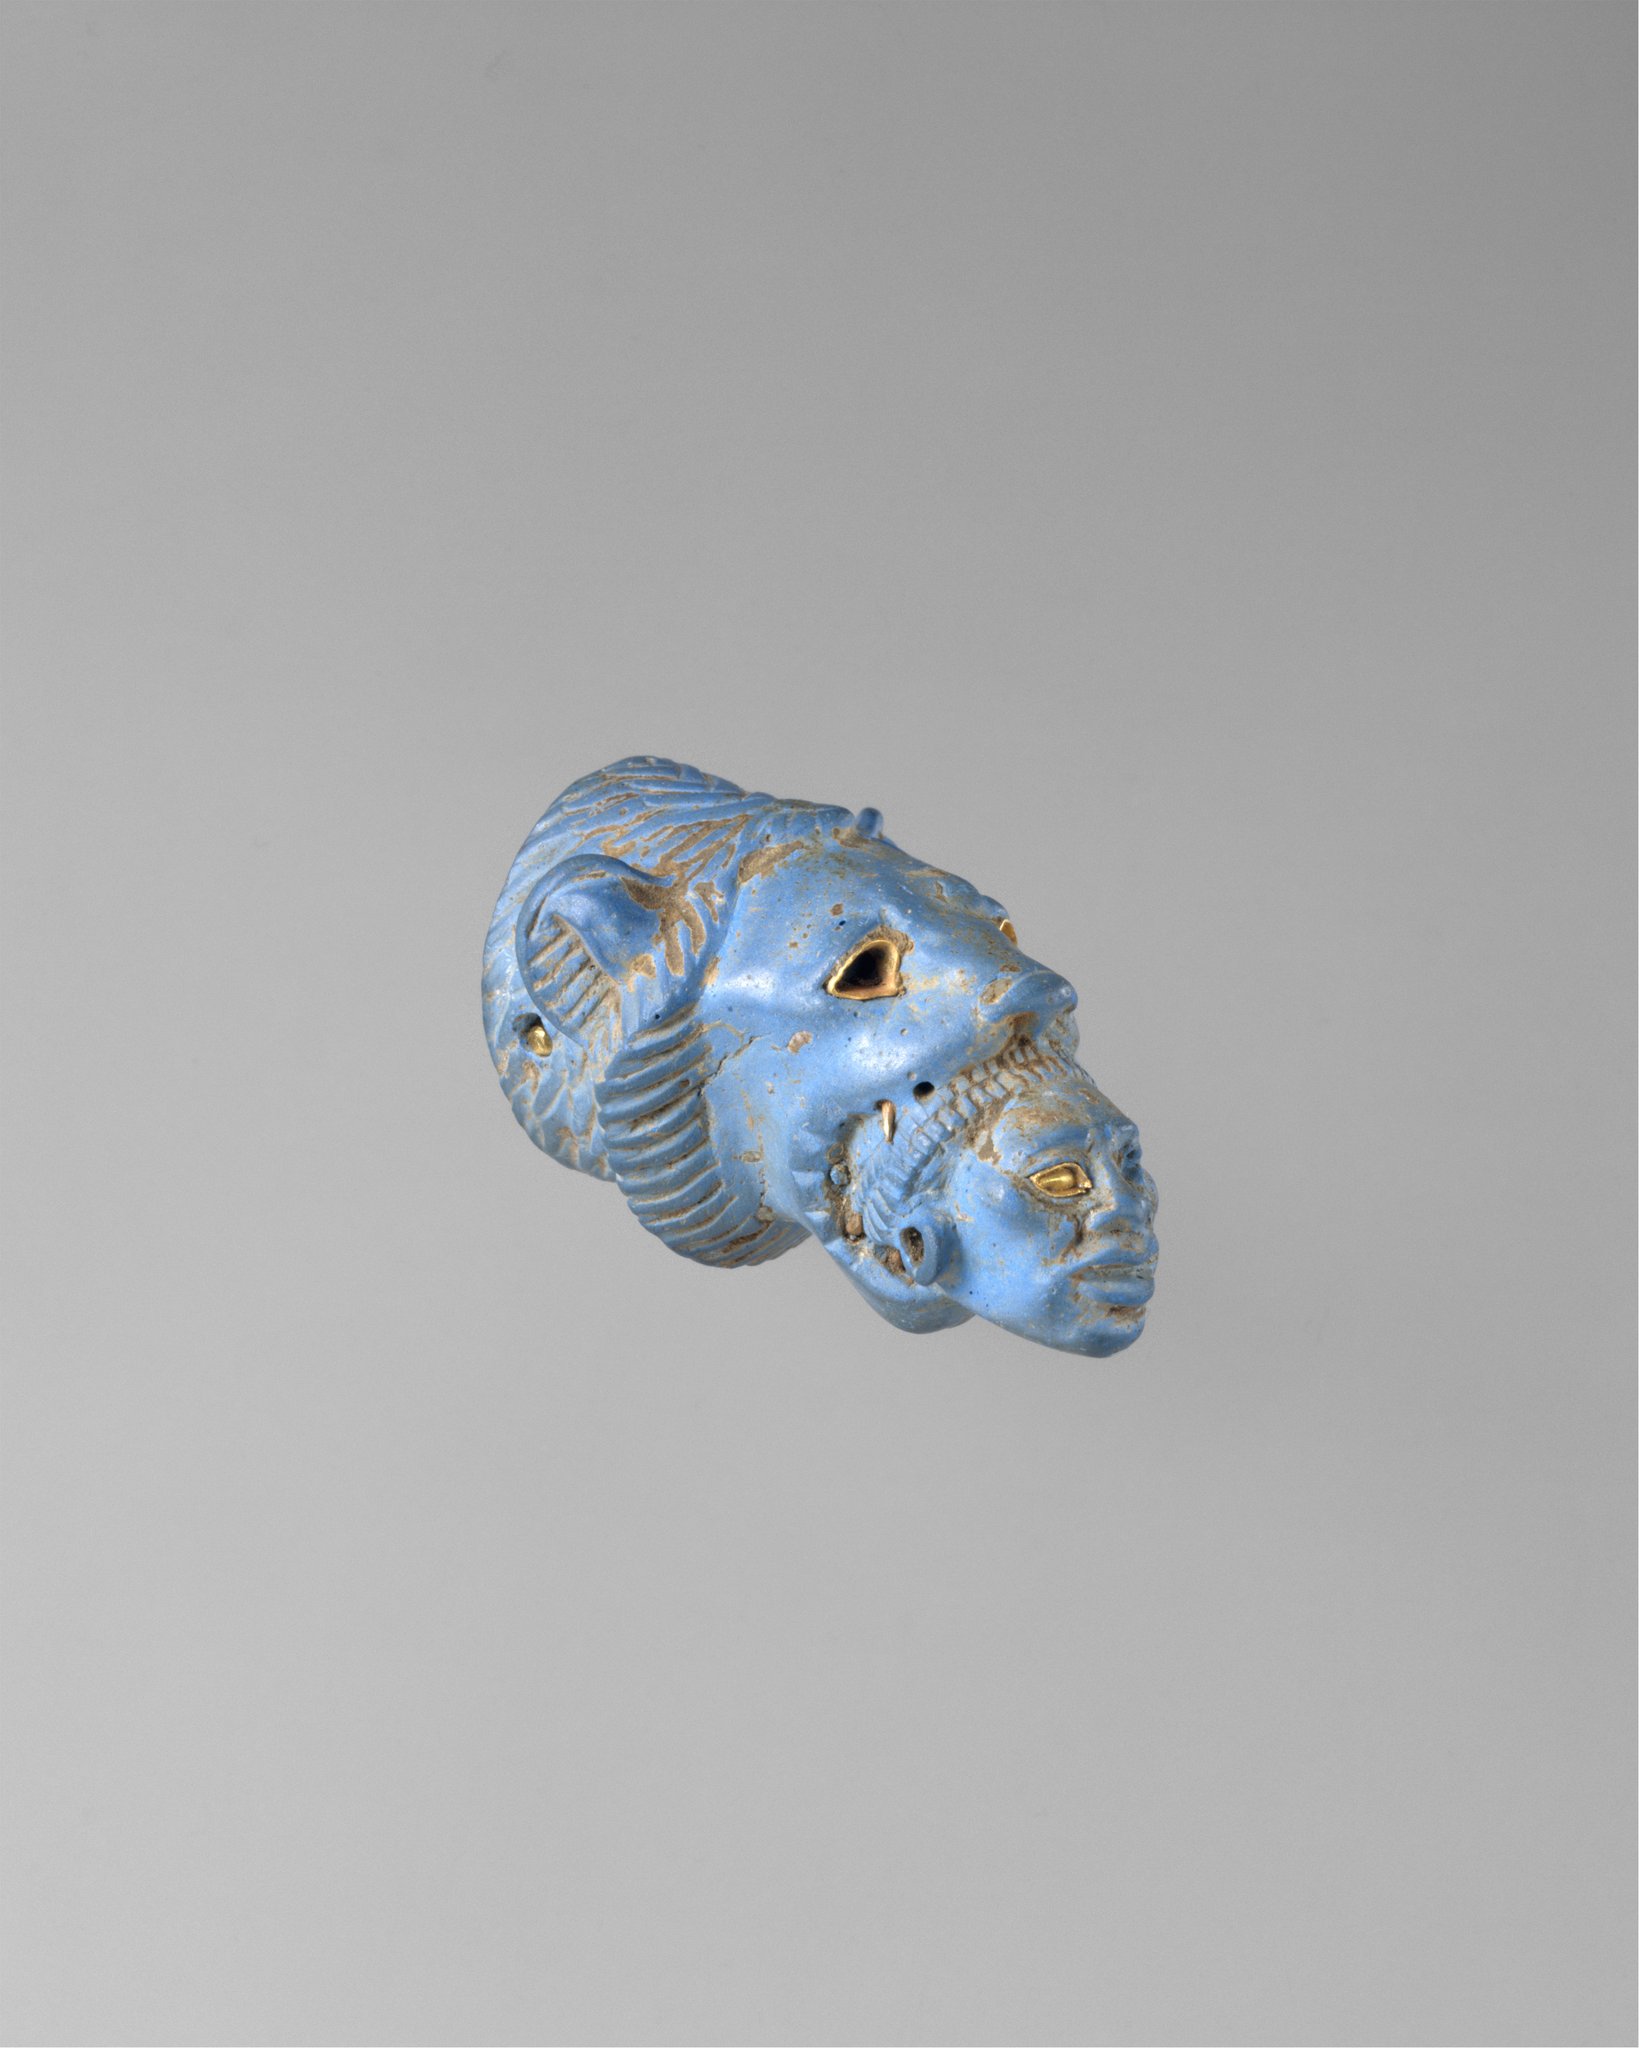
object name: protome, whip handle, lion, nubian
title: Handle Depicting a Lion Subduing a Nubian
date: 1279-1213 BCE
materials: gold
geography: eastern delta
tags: lions